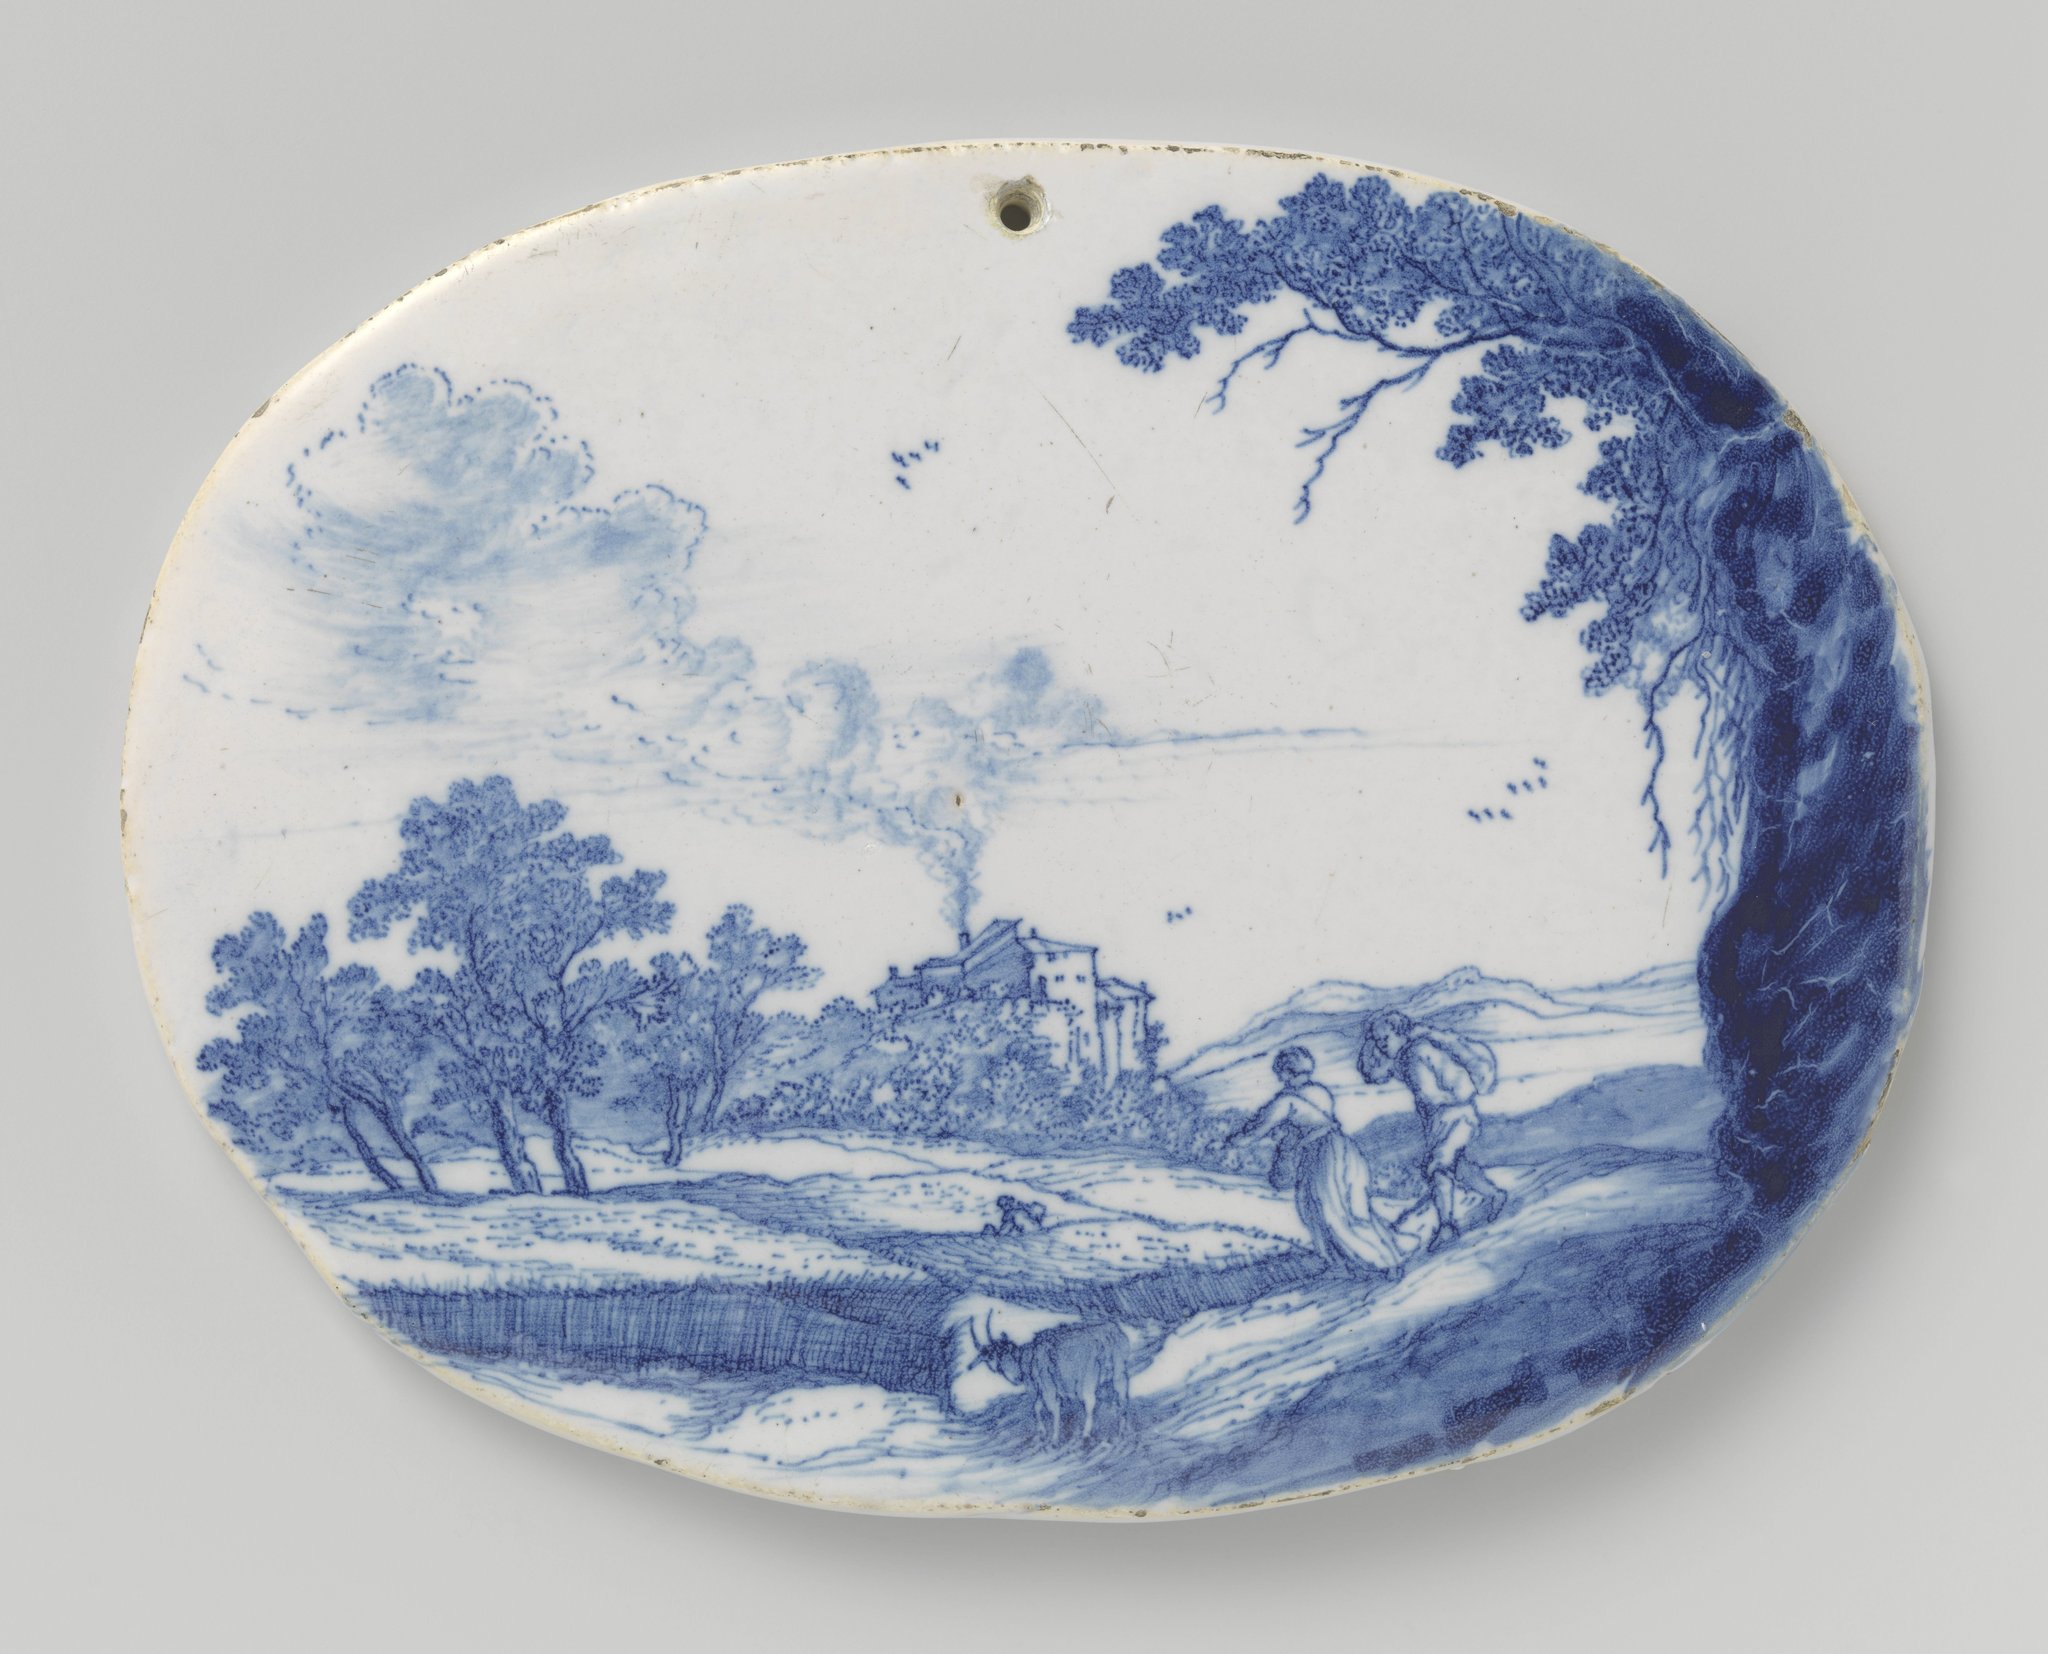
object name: plate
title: Two oval plaques with landscapes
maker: Anonymous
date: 1650-1675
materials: earthenware, glaze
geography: delft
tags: smoke-stack, landscapes in the temperate zone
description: Plaat van faïence, beschilderd met een landschap in blauw.